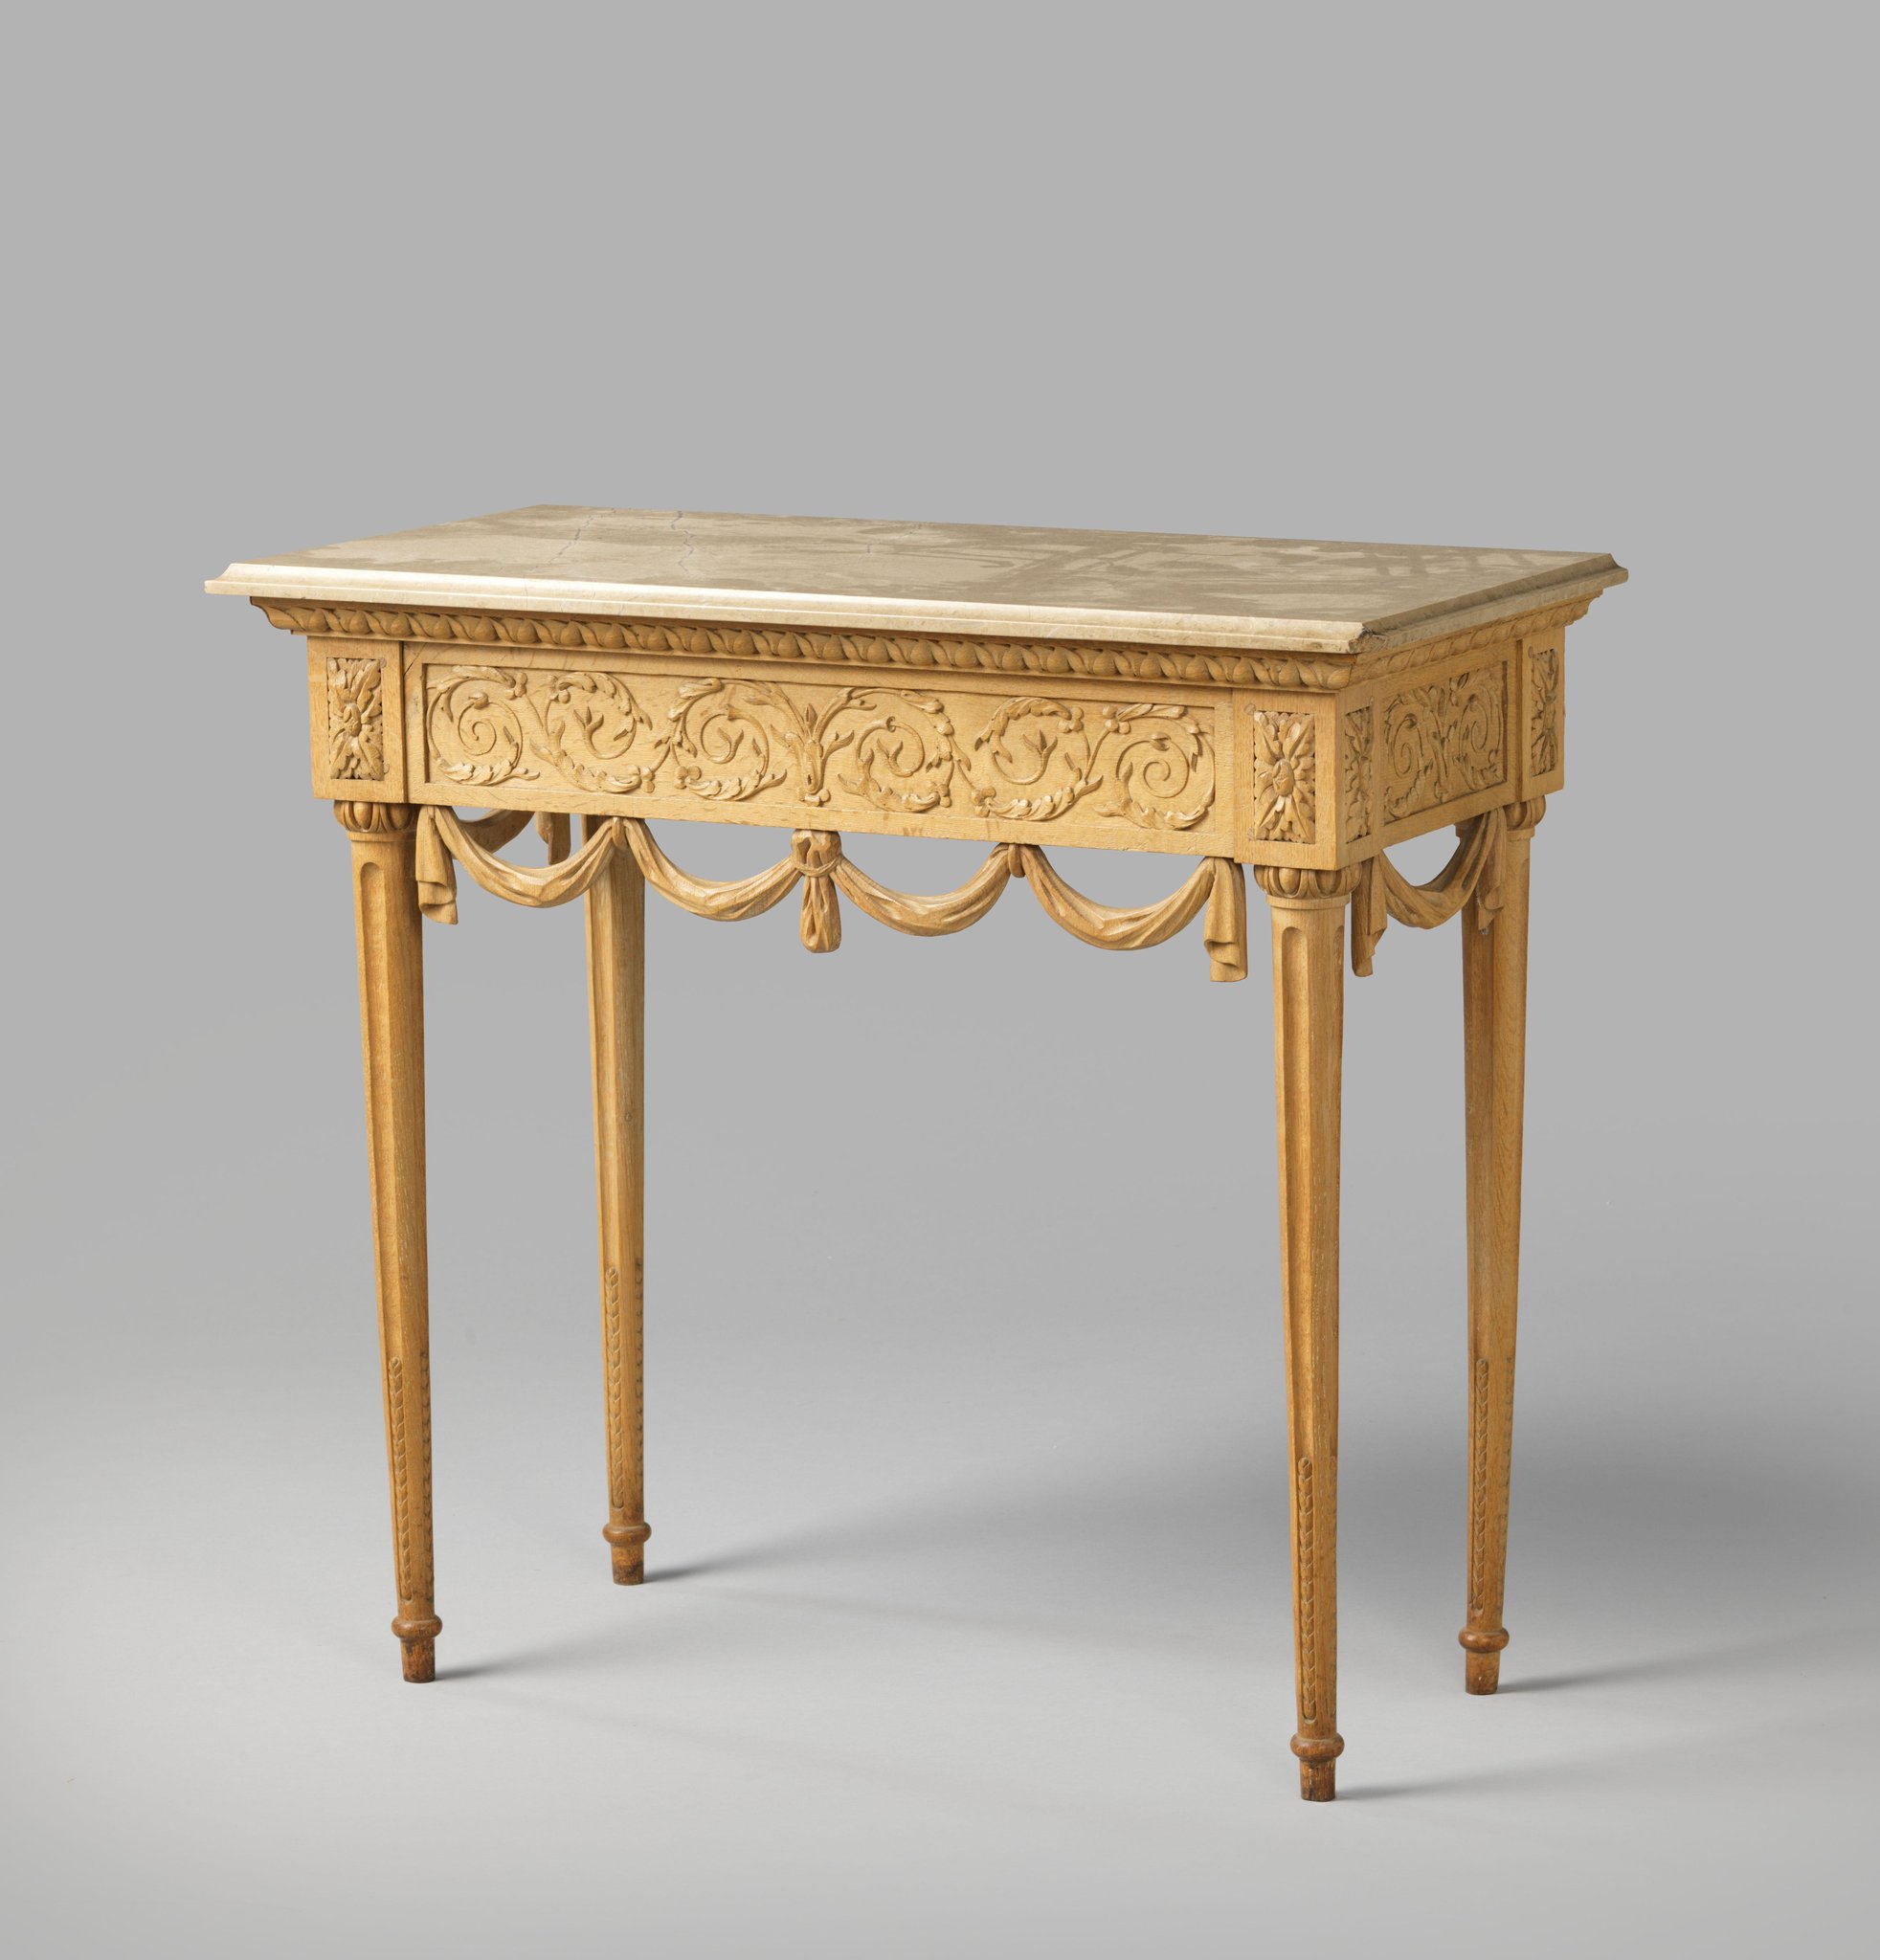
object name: pier table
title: Penanttafel met gecanneleerde poten en acanthus- en draperieversieringen langs de regels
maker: Anonymous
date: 1775-1800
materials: marble, wood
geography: netherlands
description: Penanttafel van eikenhout met vernieuwd marmeren blad. De gecanneluurde conische poten zijn van onderen met bladwerk versierd. De huizen boven de poten hebben een rozet. De voor- en zijregels hebben in reliëf symmetrische acanthusbladranken en aan de onderkant een gestoken draperie. De tafel was oorspronkelijk blauw en wit geschilderd.